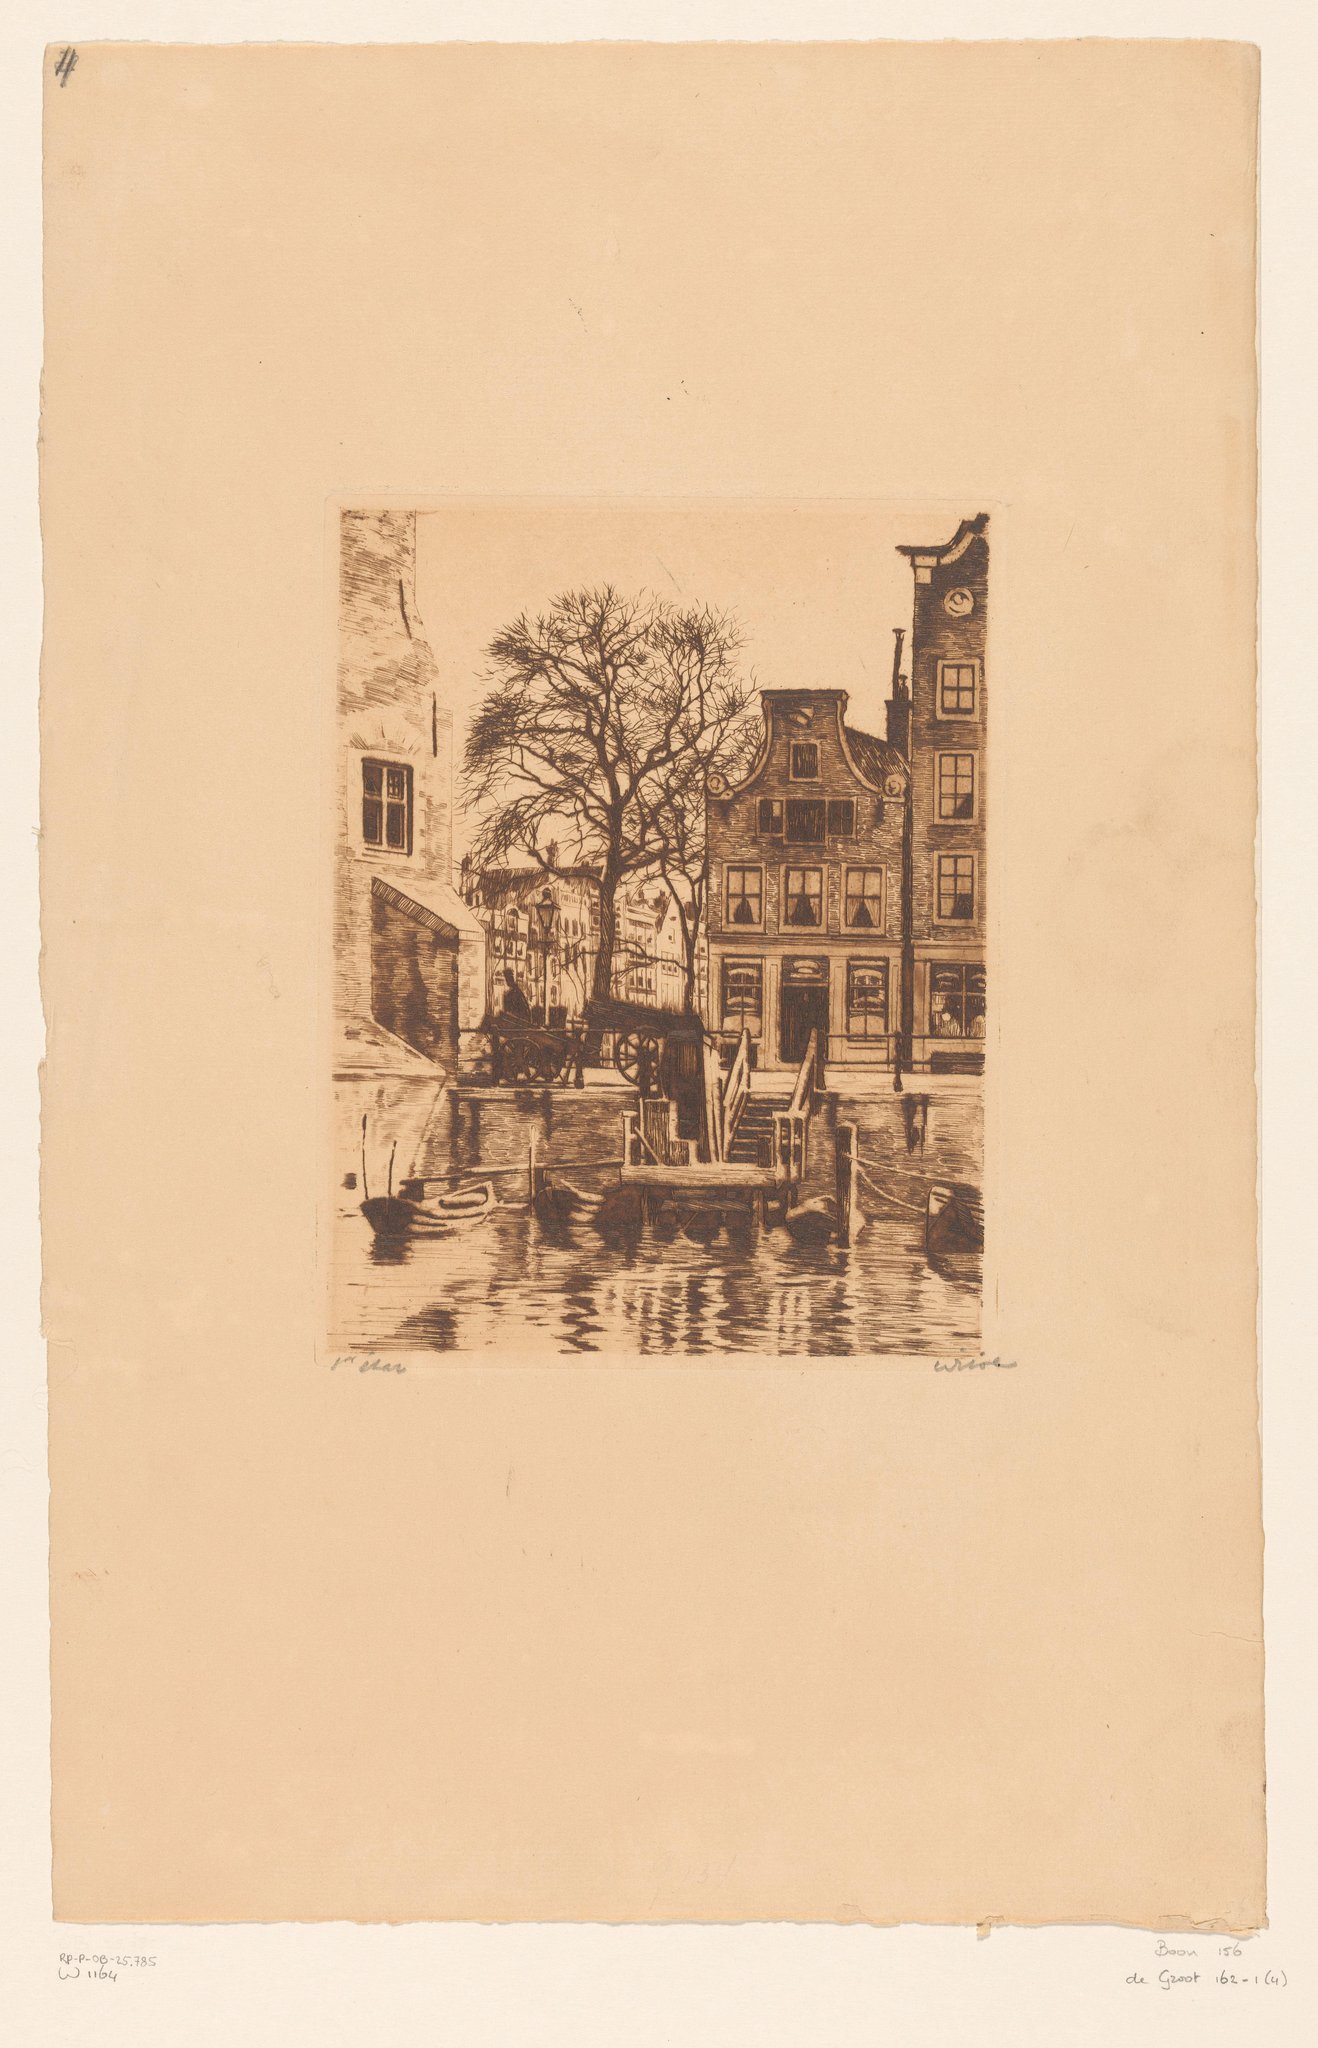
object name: print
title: Overhaal bij de Montelbaanstoren in Amsterdam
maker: willem witsen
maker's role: draughtsman, painter, print maker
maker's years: 1860-1923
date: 1912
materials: paper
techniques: aquatint, etching, intaglio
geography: amsterdam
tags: city-view, and landscape with man-made constructions, canals, waters (in city), the usual house or row of houses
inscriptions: watermark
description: Gezien vanaf de Oude Schans richting de Oude Schans 4.